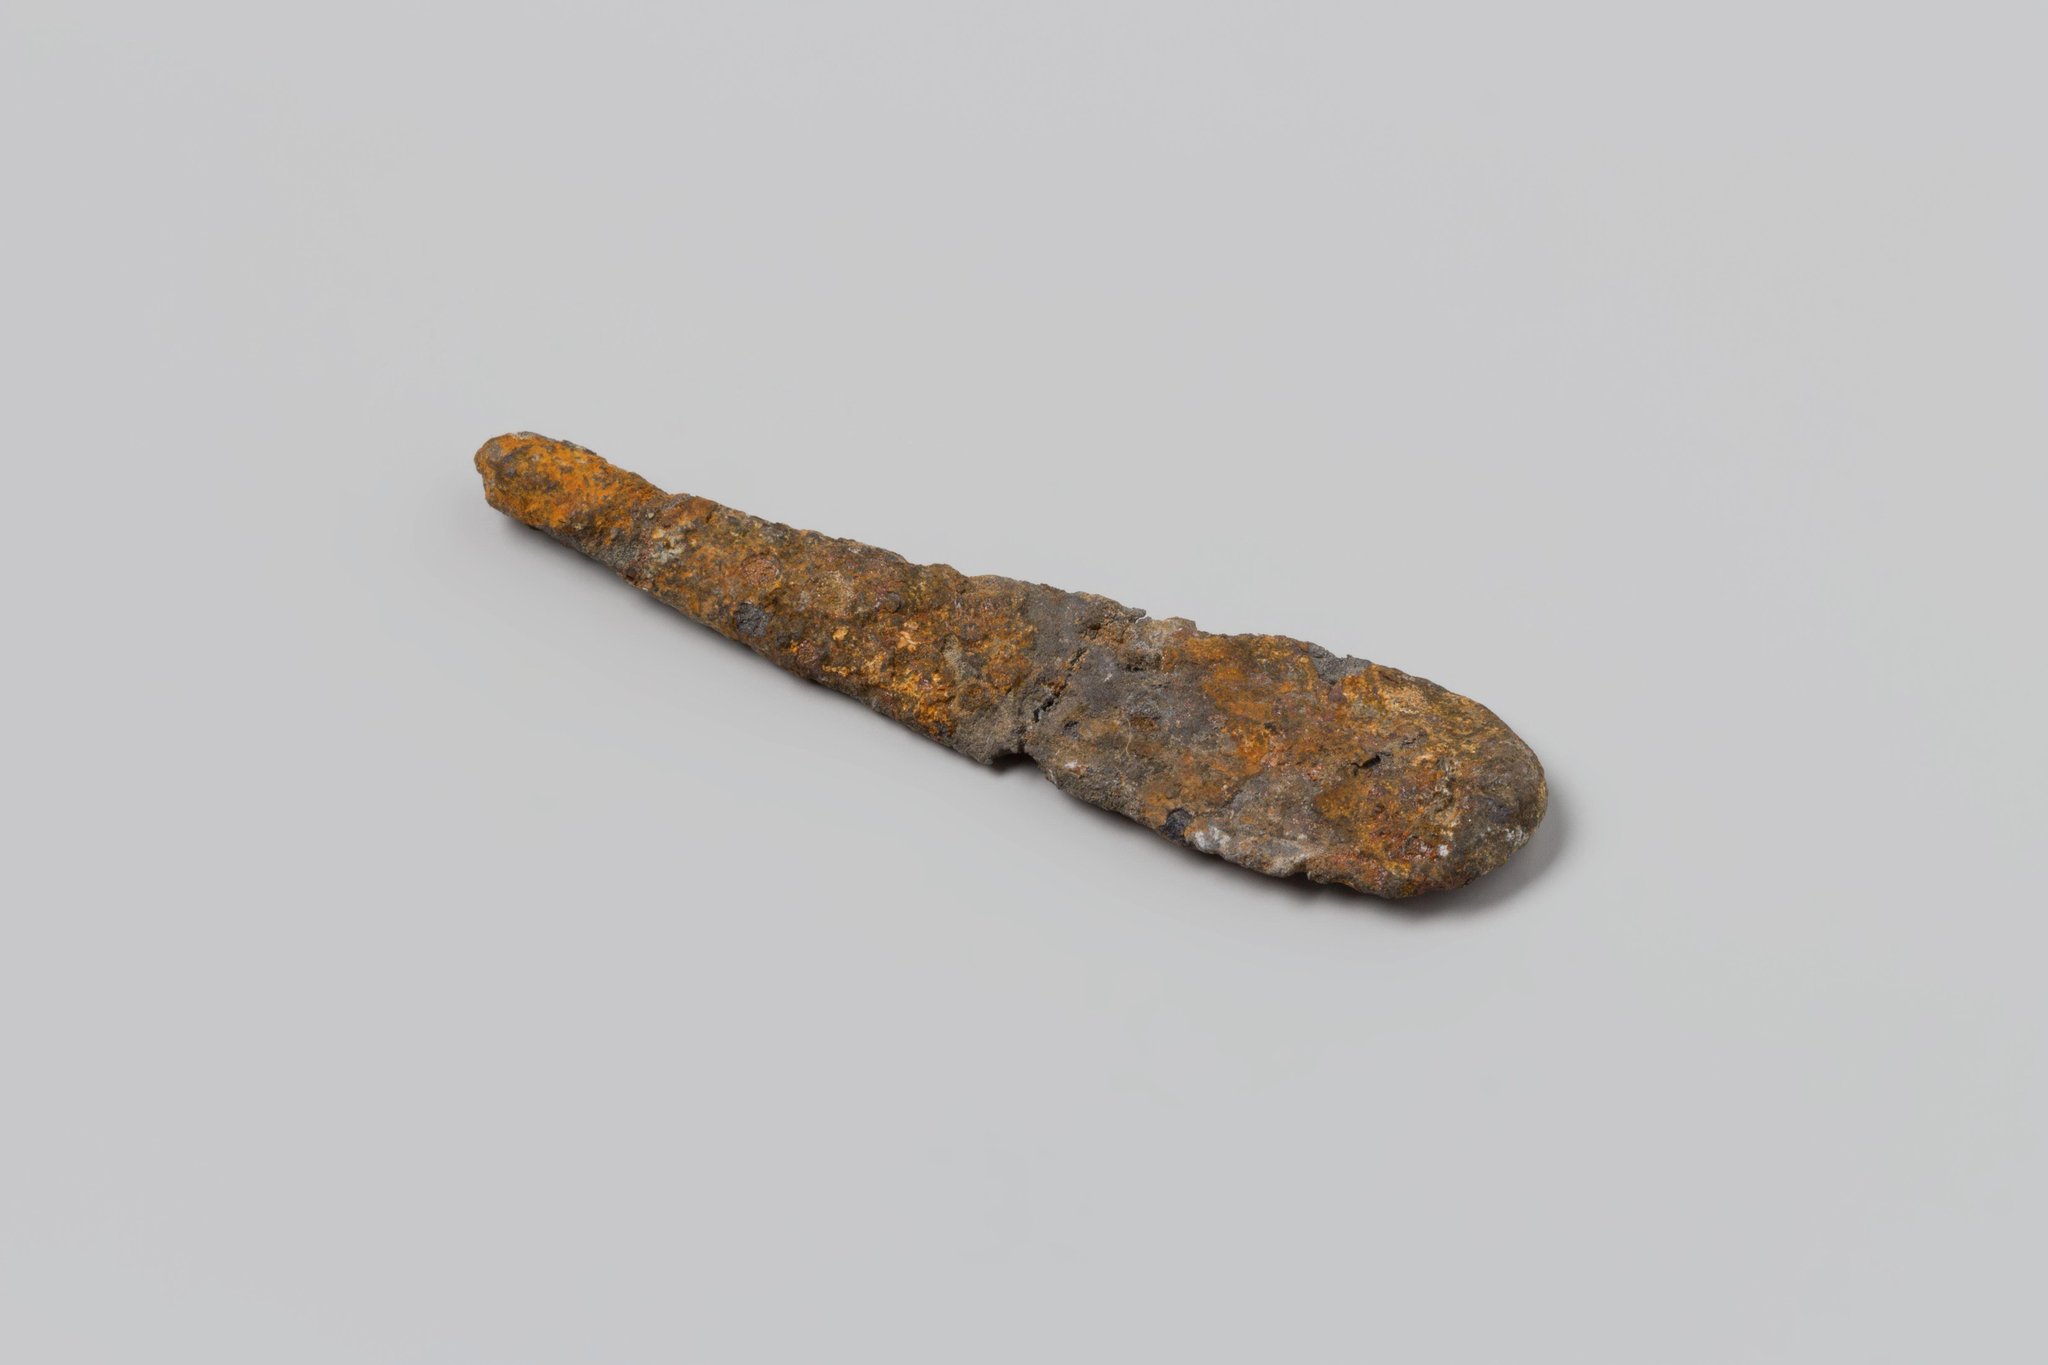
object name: spoon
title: Steel van vork of lepel uit het wrak van de Oost-Indiëvaarder Hollandia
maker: Anonymous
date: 1700-1743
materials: tin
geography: netherlands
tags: verenigde oostindische compagnie, hollandia (schip), annet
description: Cutlery, fragment: stem of fork or spoon; fragm, id. NG 1980-27H67.